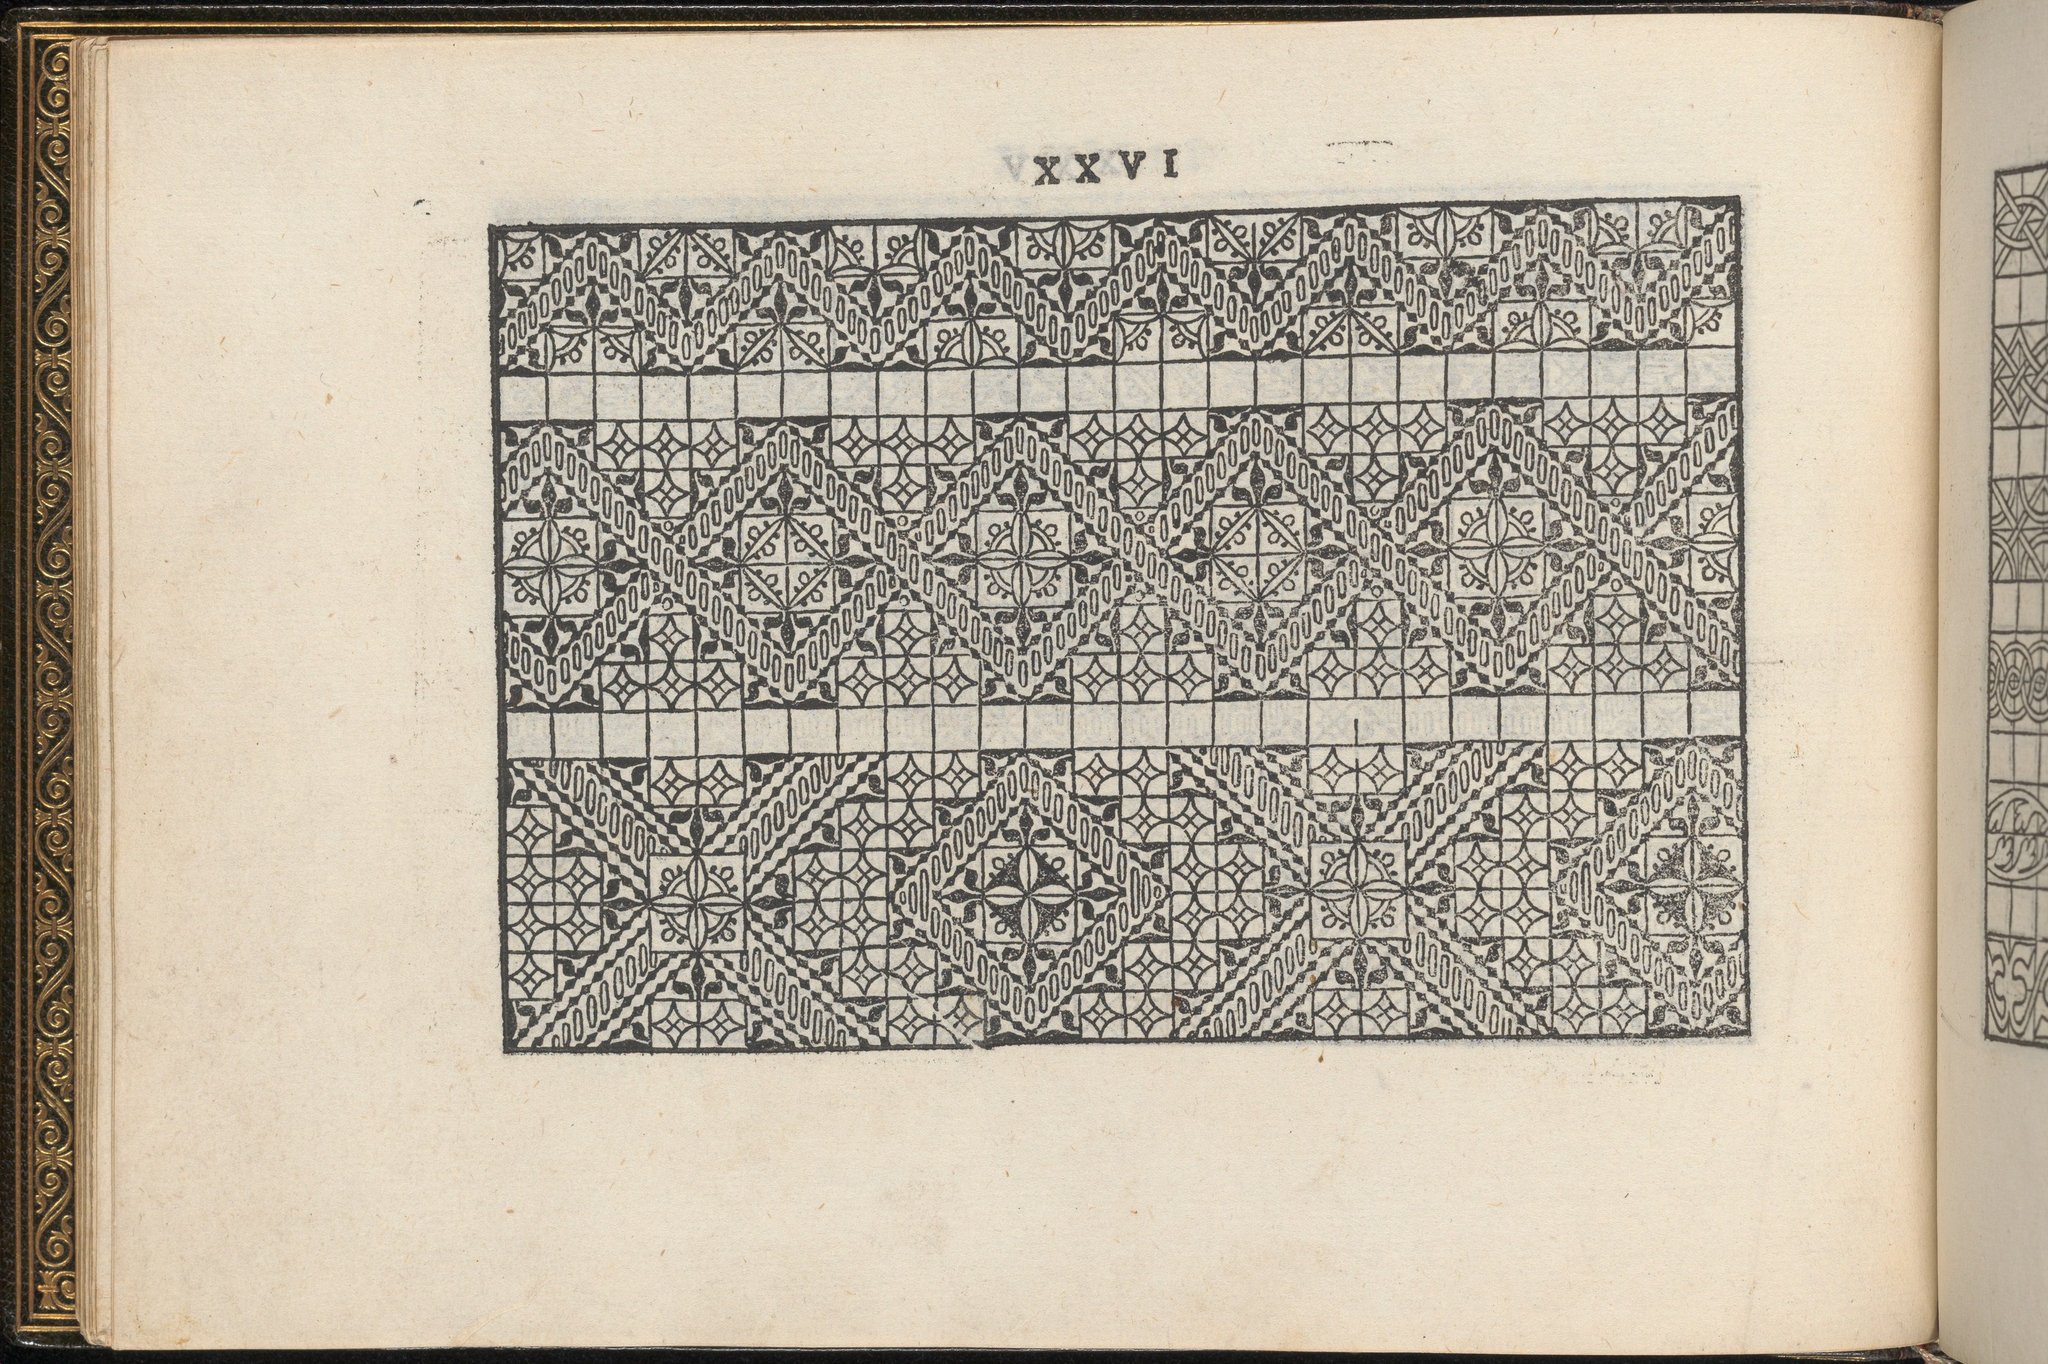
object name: book print ornament architecture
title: La Vera Perfettione del Disegno di varie sorti di recami, page 13 (verso)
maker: giovanni ostaus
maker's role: publisher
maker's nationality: italian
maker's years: 1507-1607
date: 1567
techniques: woodcut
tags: ornament